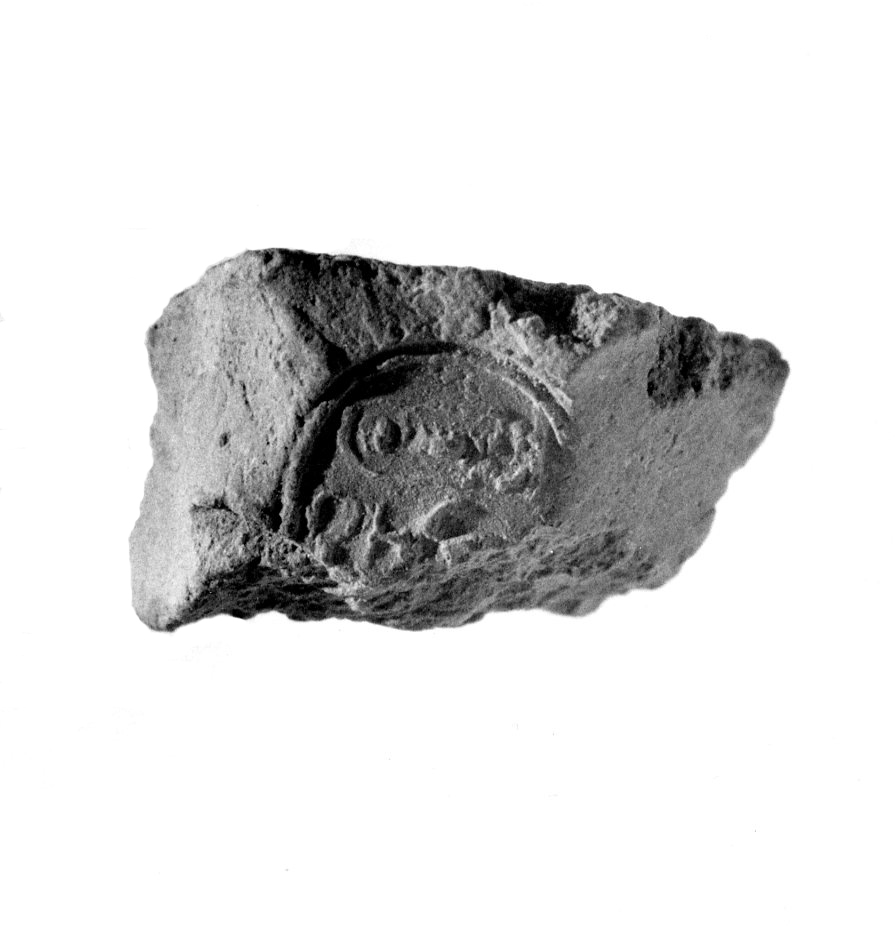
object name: sealing, thutmose iv, menkheperure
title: Document Sealings With the Throne Name of Thutmose IV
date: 1390-1352 BCE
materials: mud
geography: egypt